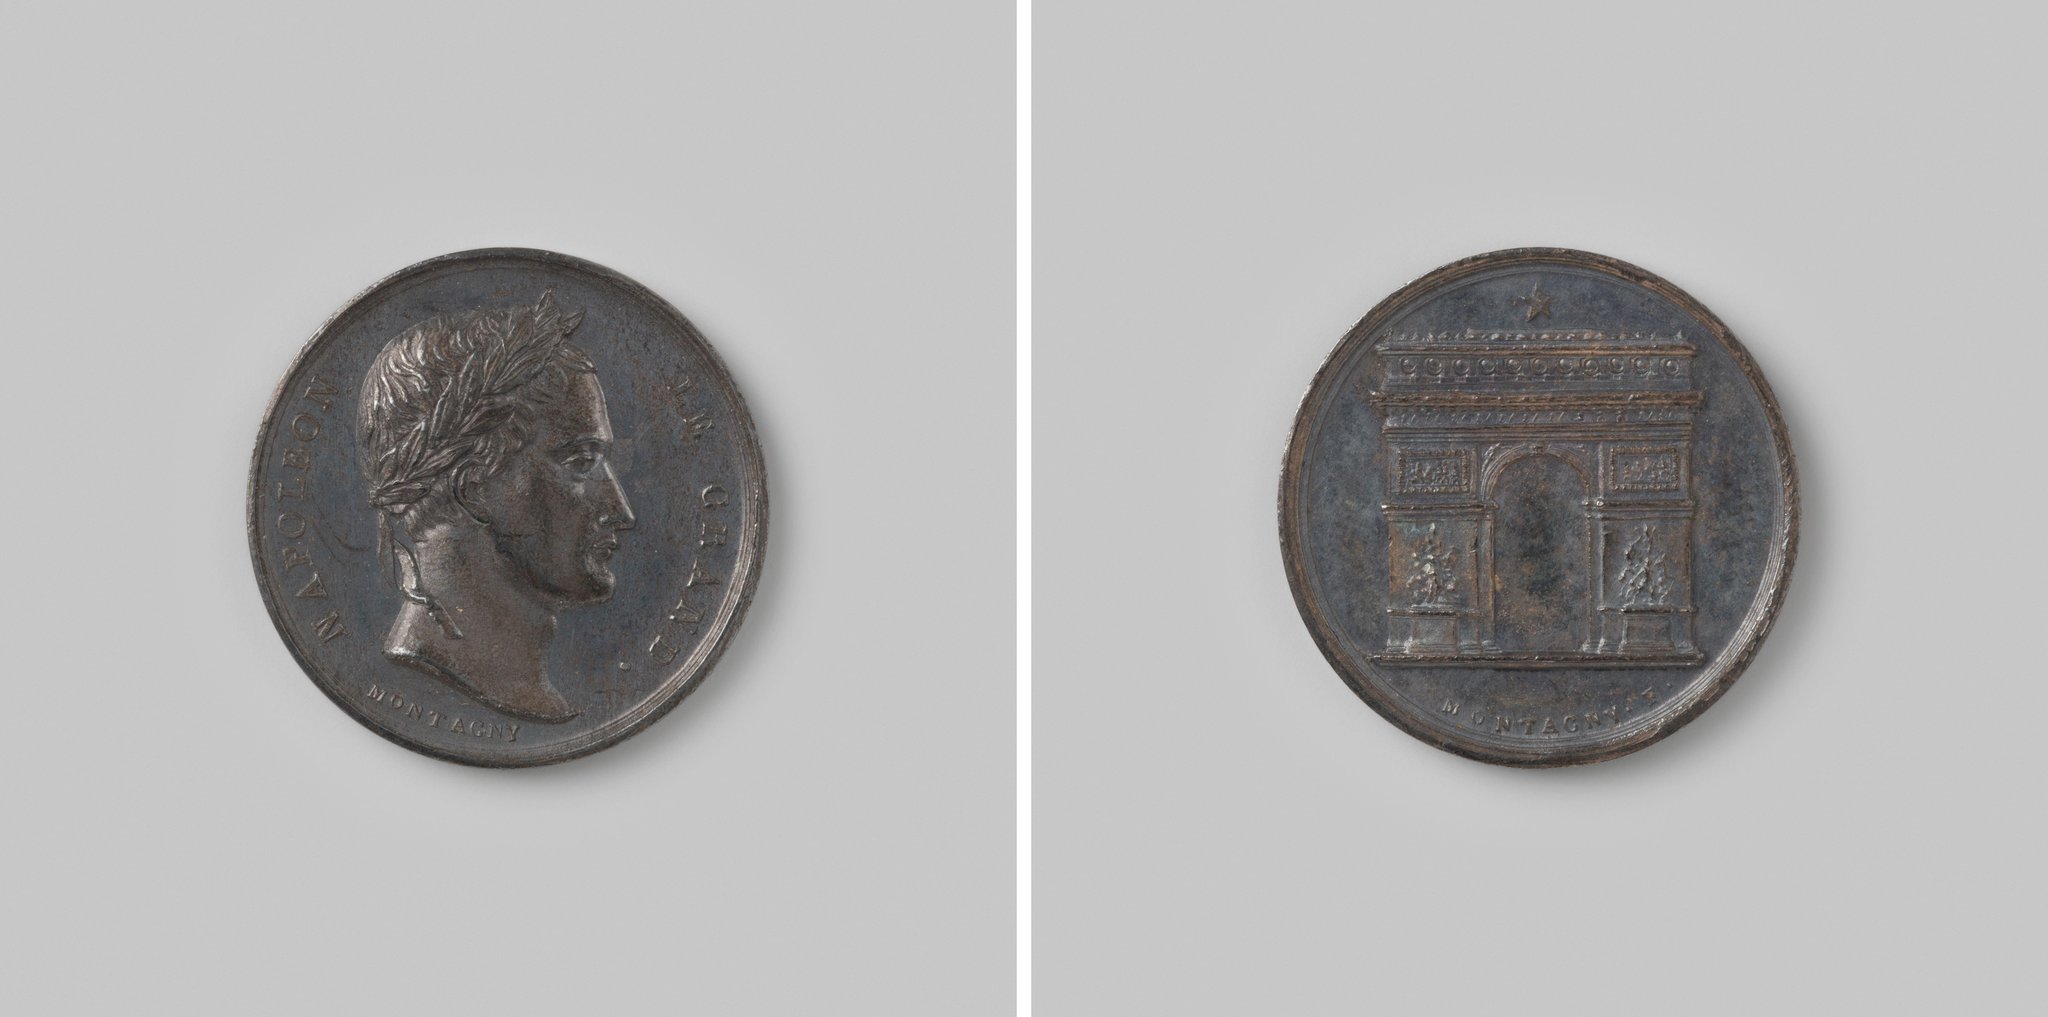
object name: history medal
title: Inwijding van de Arc de Triomphe te Parijs 1836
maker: montagny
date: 1836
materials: silver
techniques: striking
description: Zilveren penning, op de voorzijde het portret van Napoleon naar rechts met omschrift, op de keerzijde de Arc de Triomphe waarboven een ster.